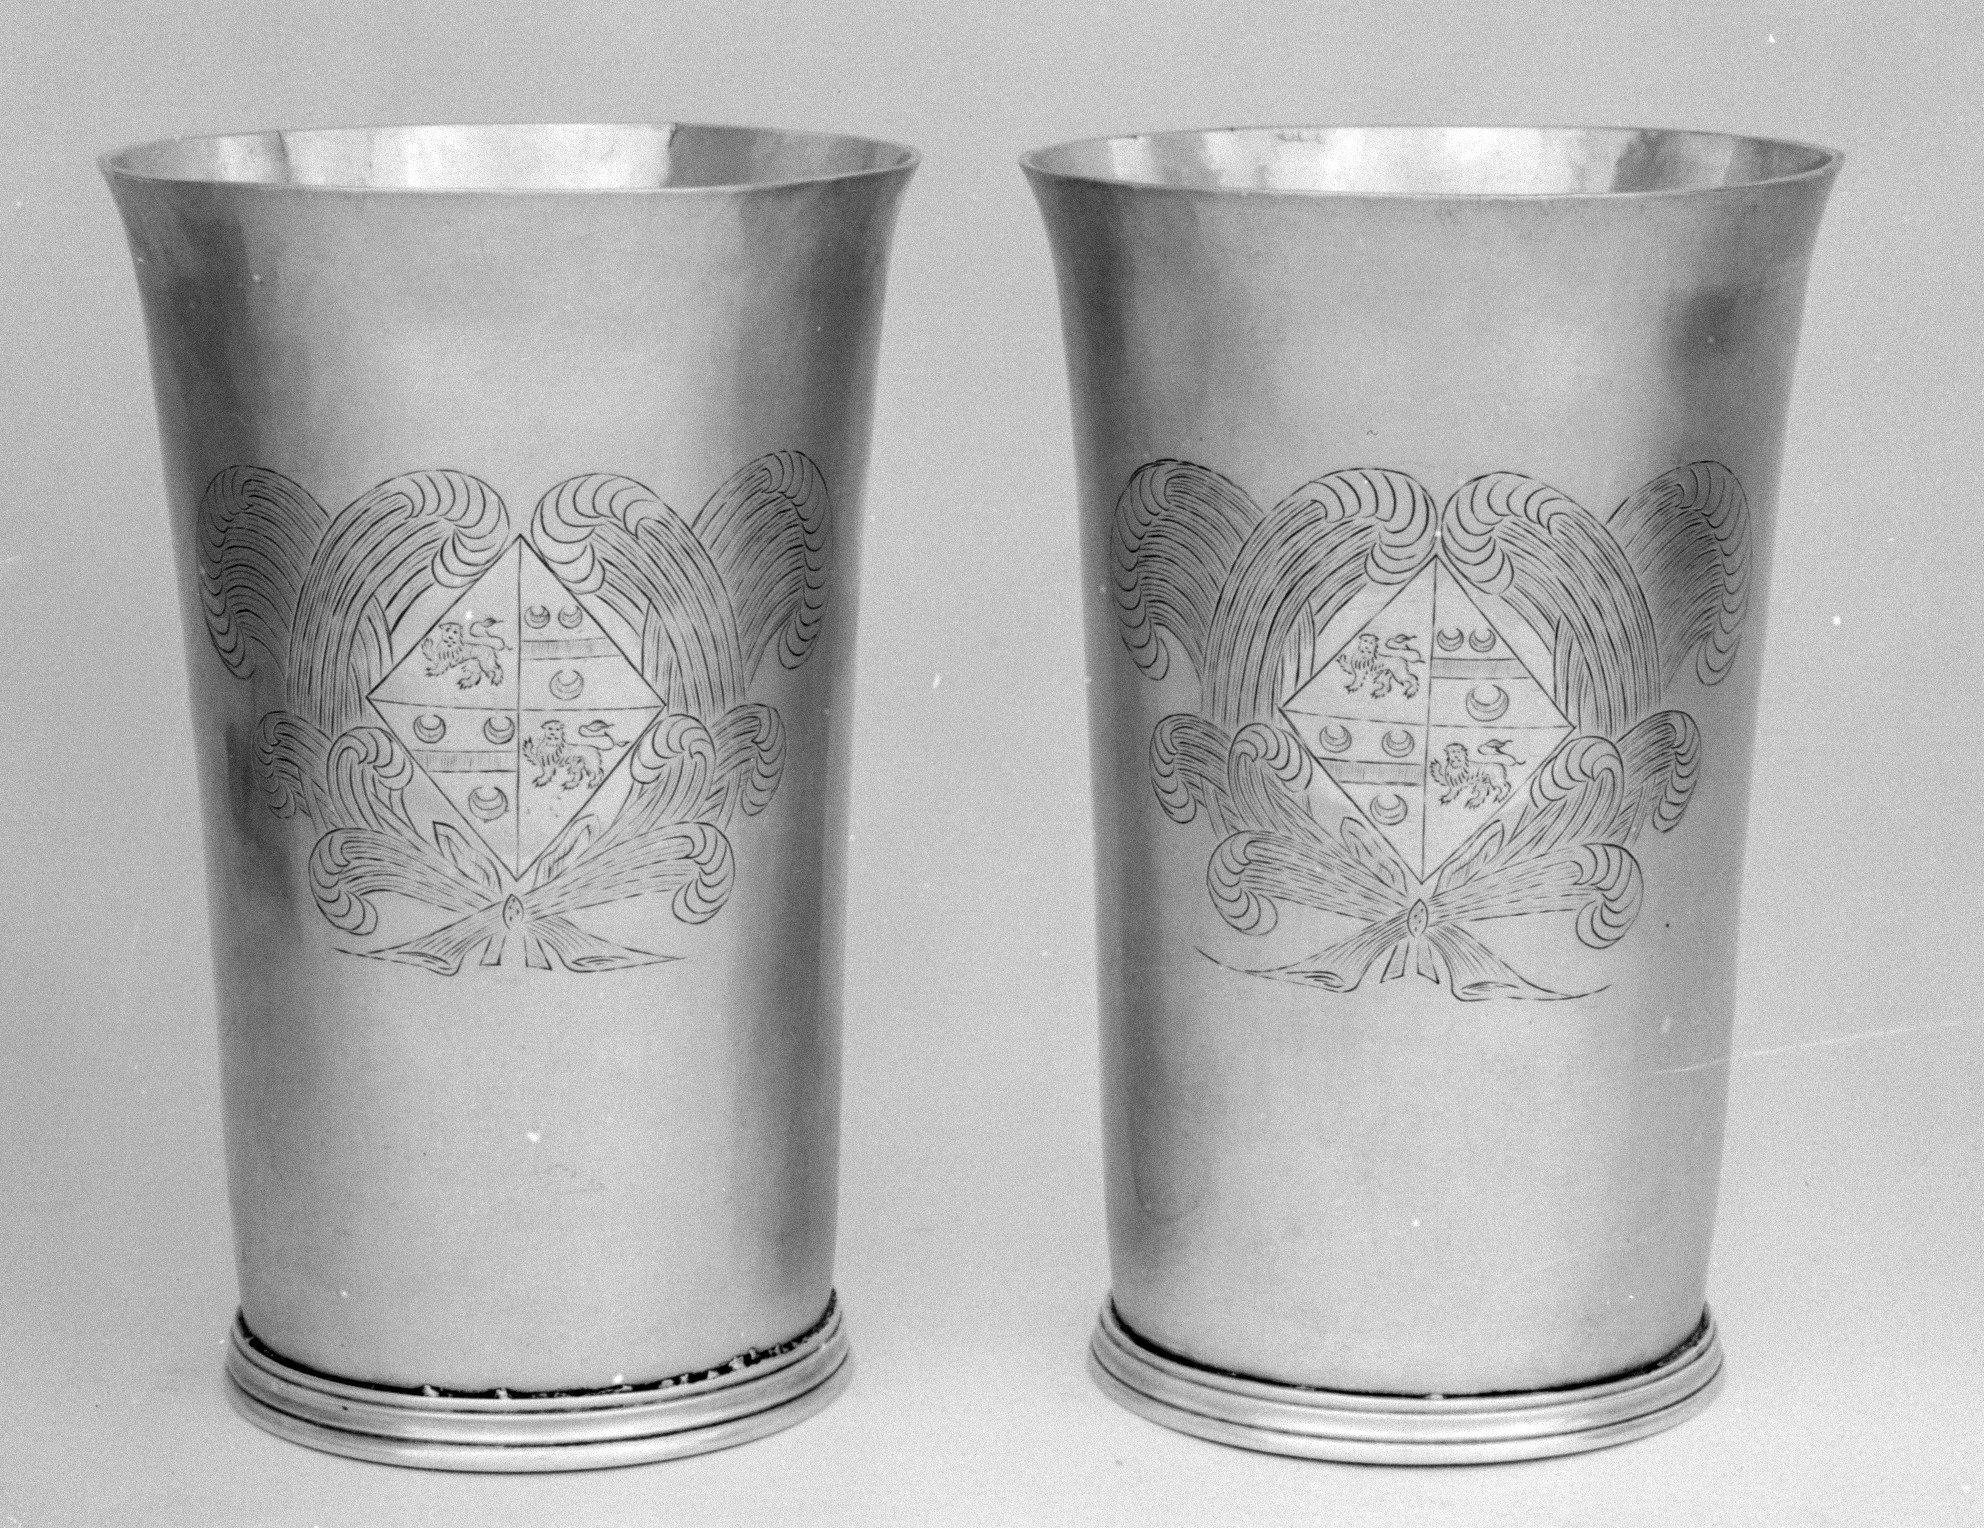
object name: beaker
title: Pair of beakers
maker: e. g., london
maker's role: maker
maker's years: 1669-1681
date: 1678-1679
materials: silver